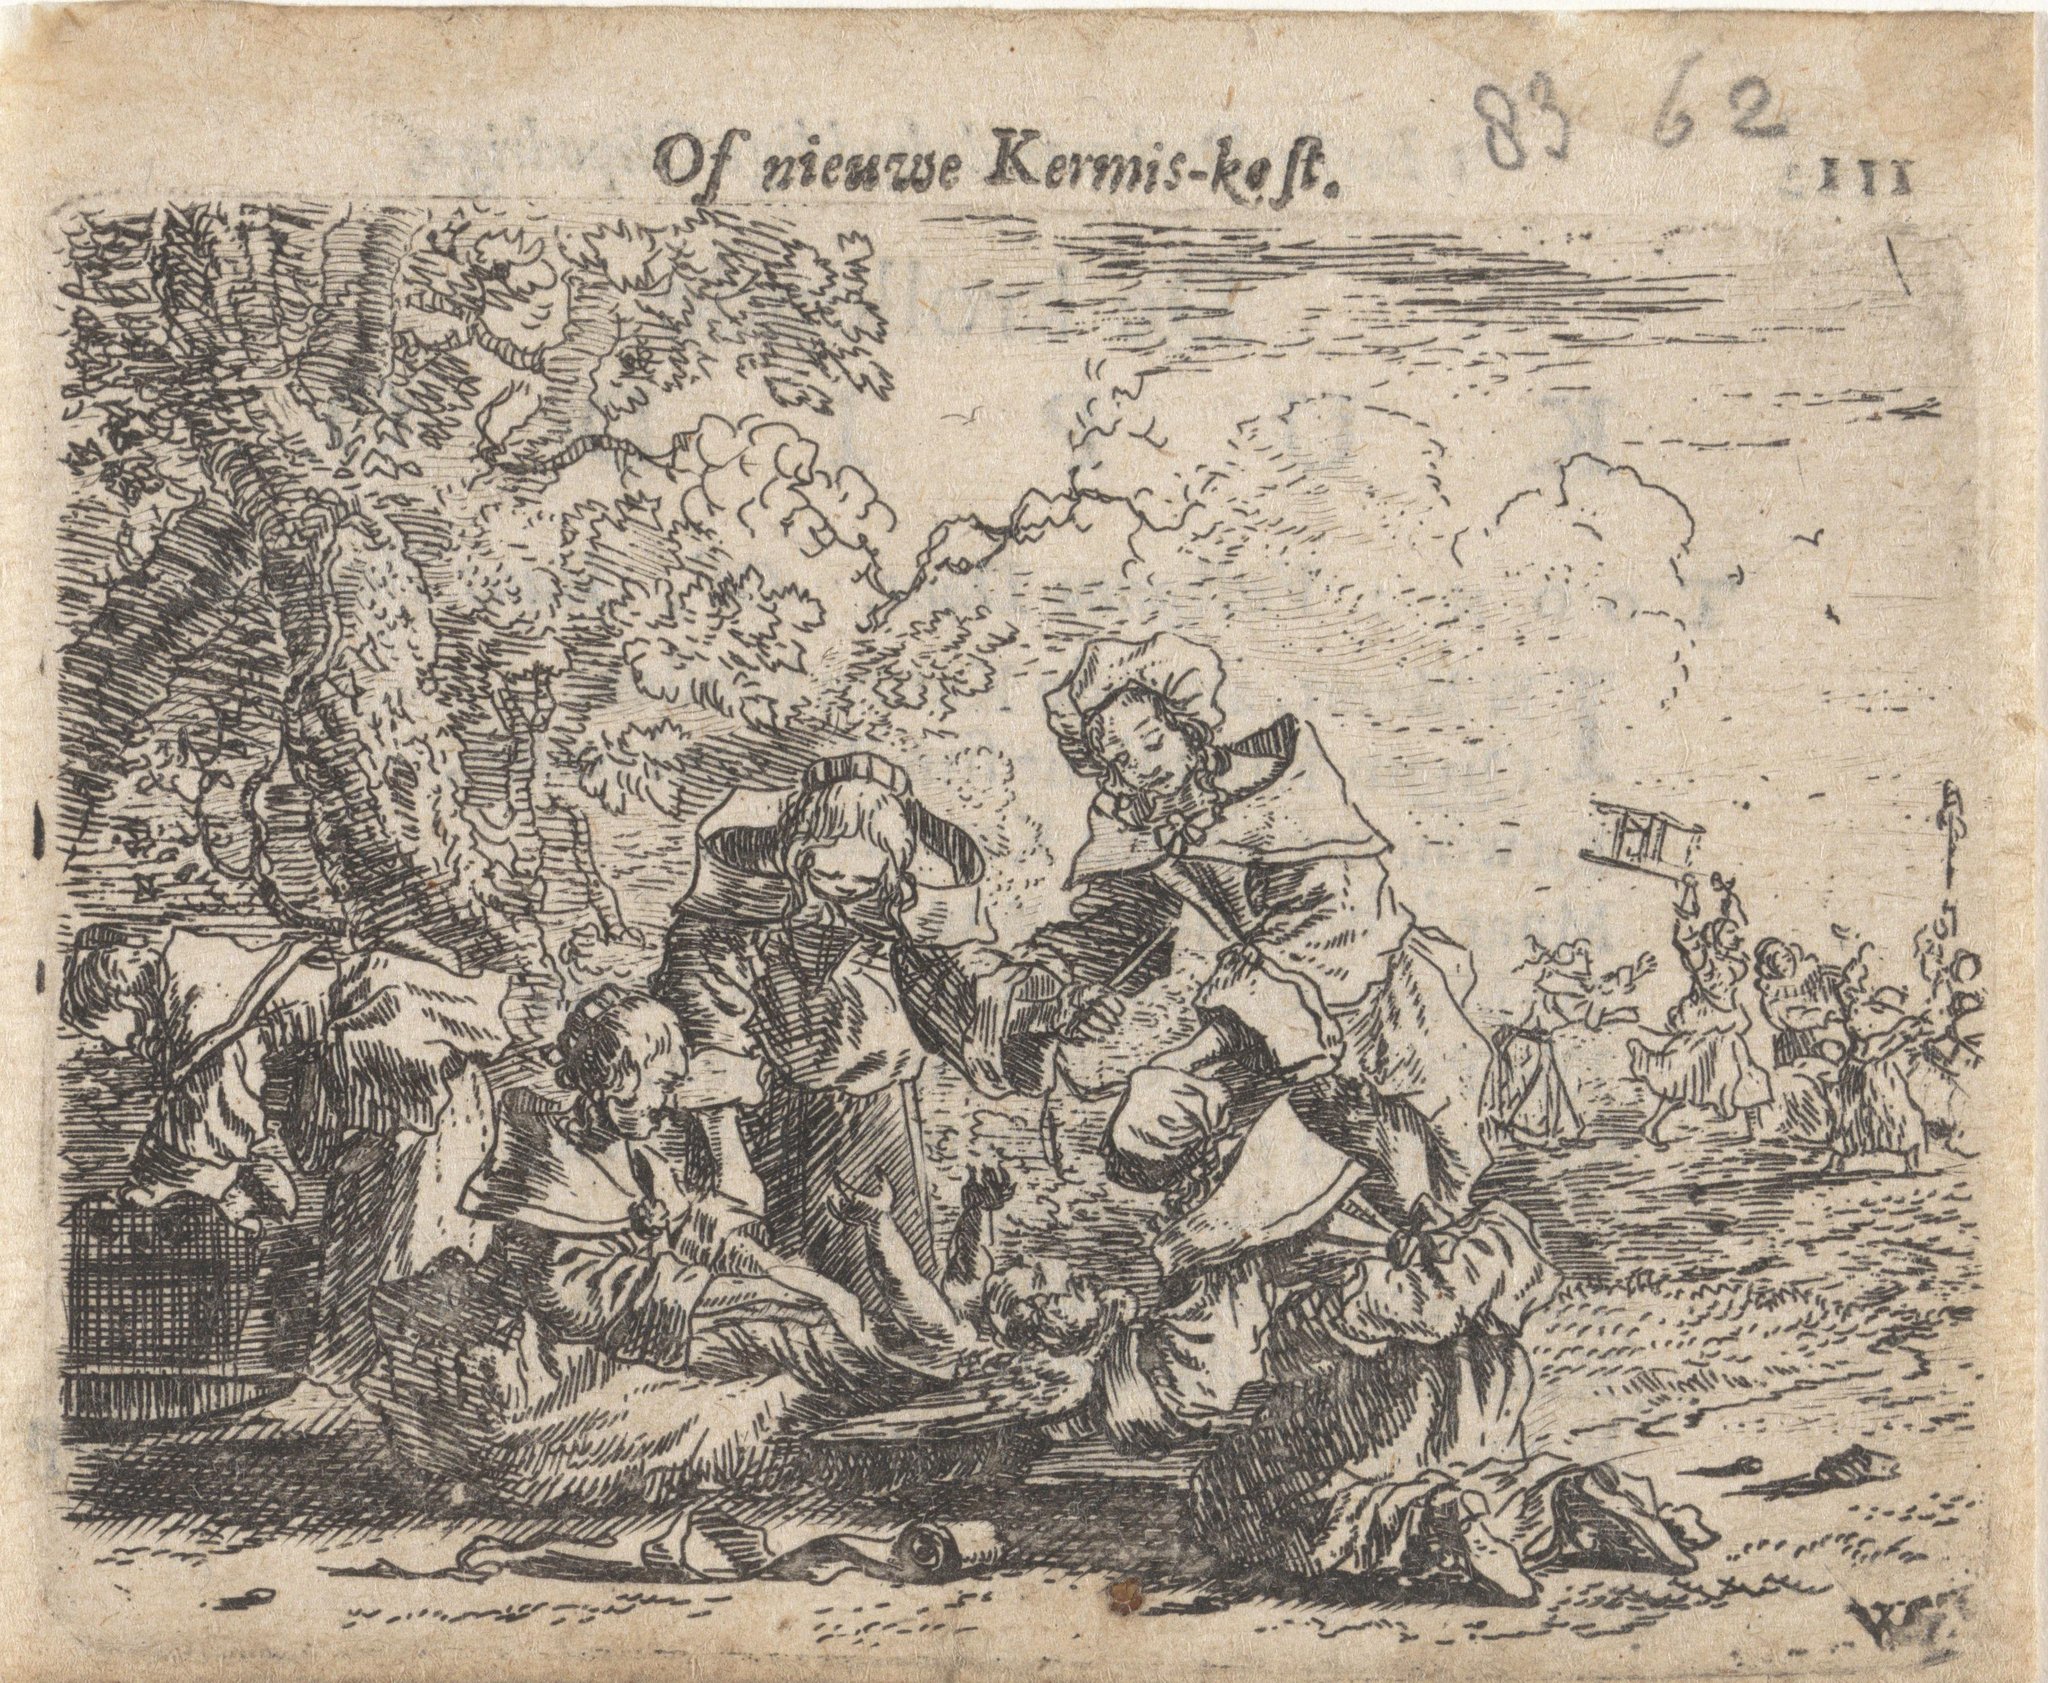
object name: book illustration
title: Vier vrouwen rond een putto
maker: willem schellinks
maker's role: draughtsman, painter, print maker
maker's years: 1627-1678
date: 1654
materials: paper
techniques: etching, letterpress printing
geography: amsterdam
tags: adult woman, cupids: 'amores', 'amoretti', 'putti'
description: Vooraan vier vrouwen rond een putto in een wieg of mand. Een vijfde vrouw staat links boven een tobbe gebogen. Rechtsachter staat een vrouw op het punt om een stoel in de richting van enkele figuren te gooien. Boven de voorstelling de tekst: Of nieuwe Kermis-kost en het paginanummer 111. Verso een tekstblad met de liedtekst van: De krollende Cupido.